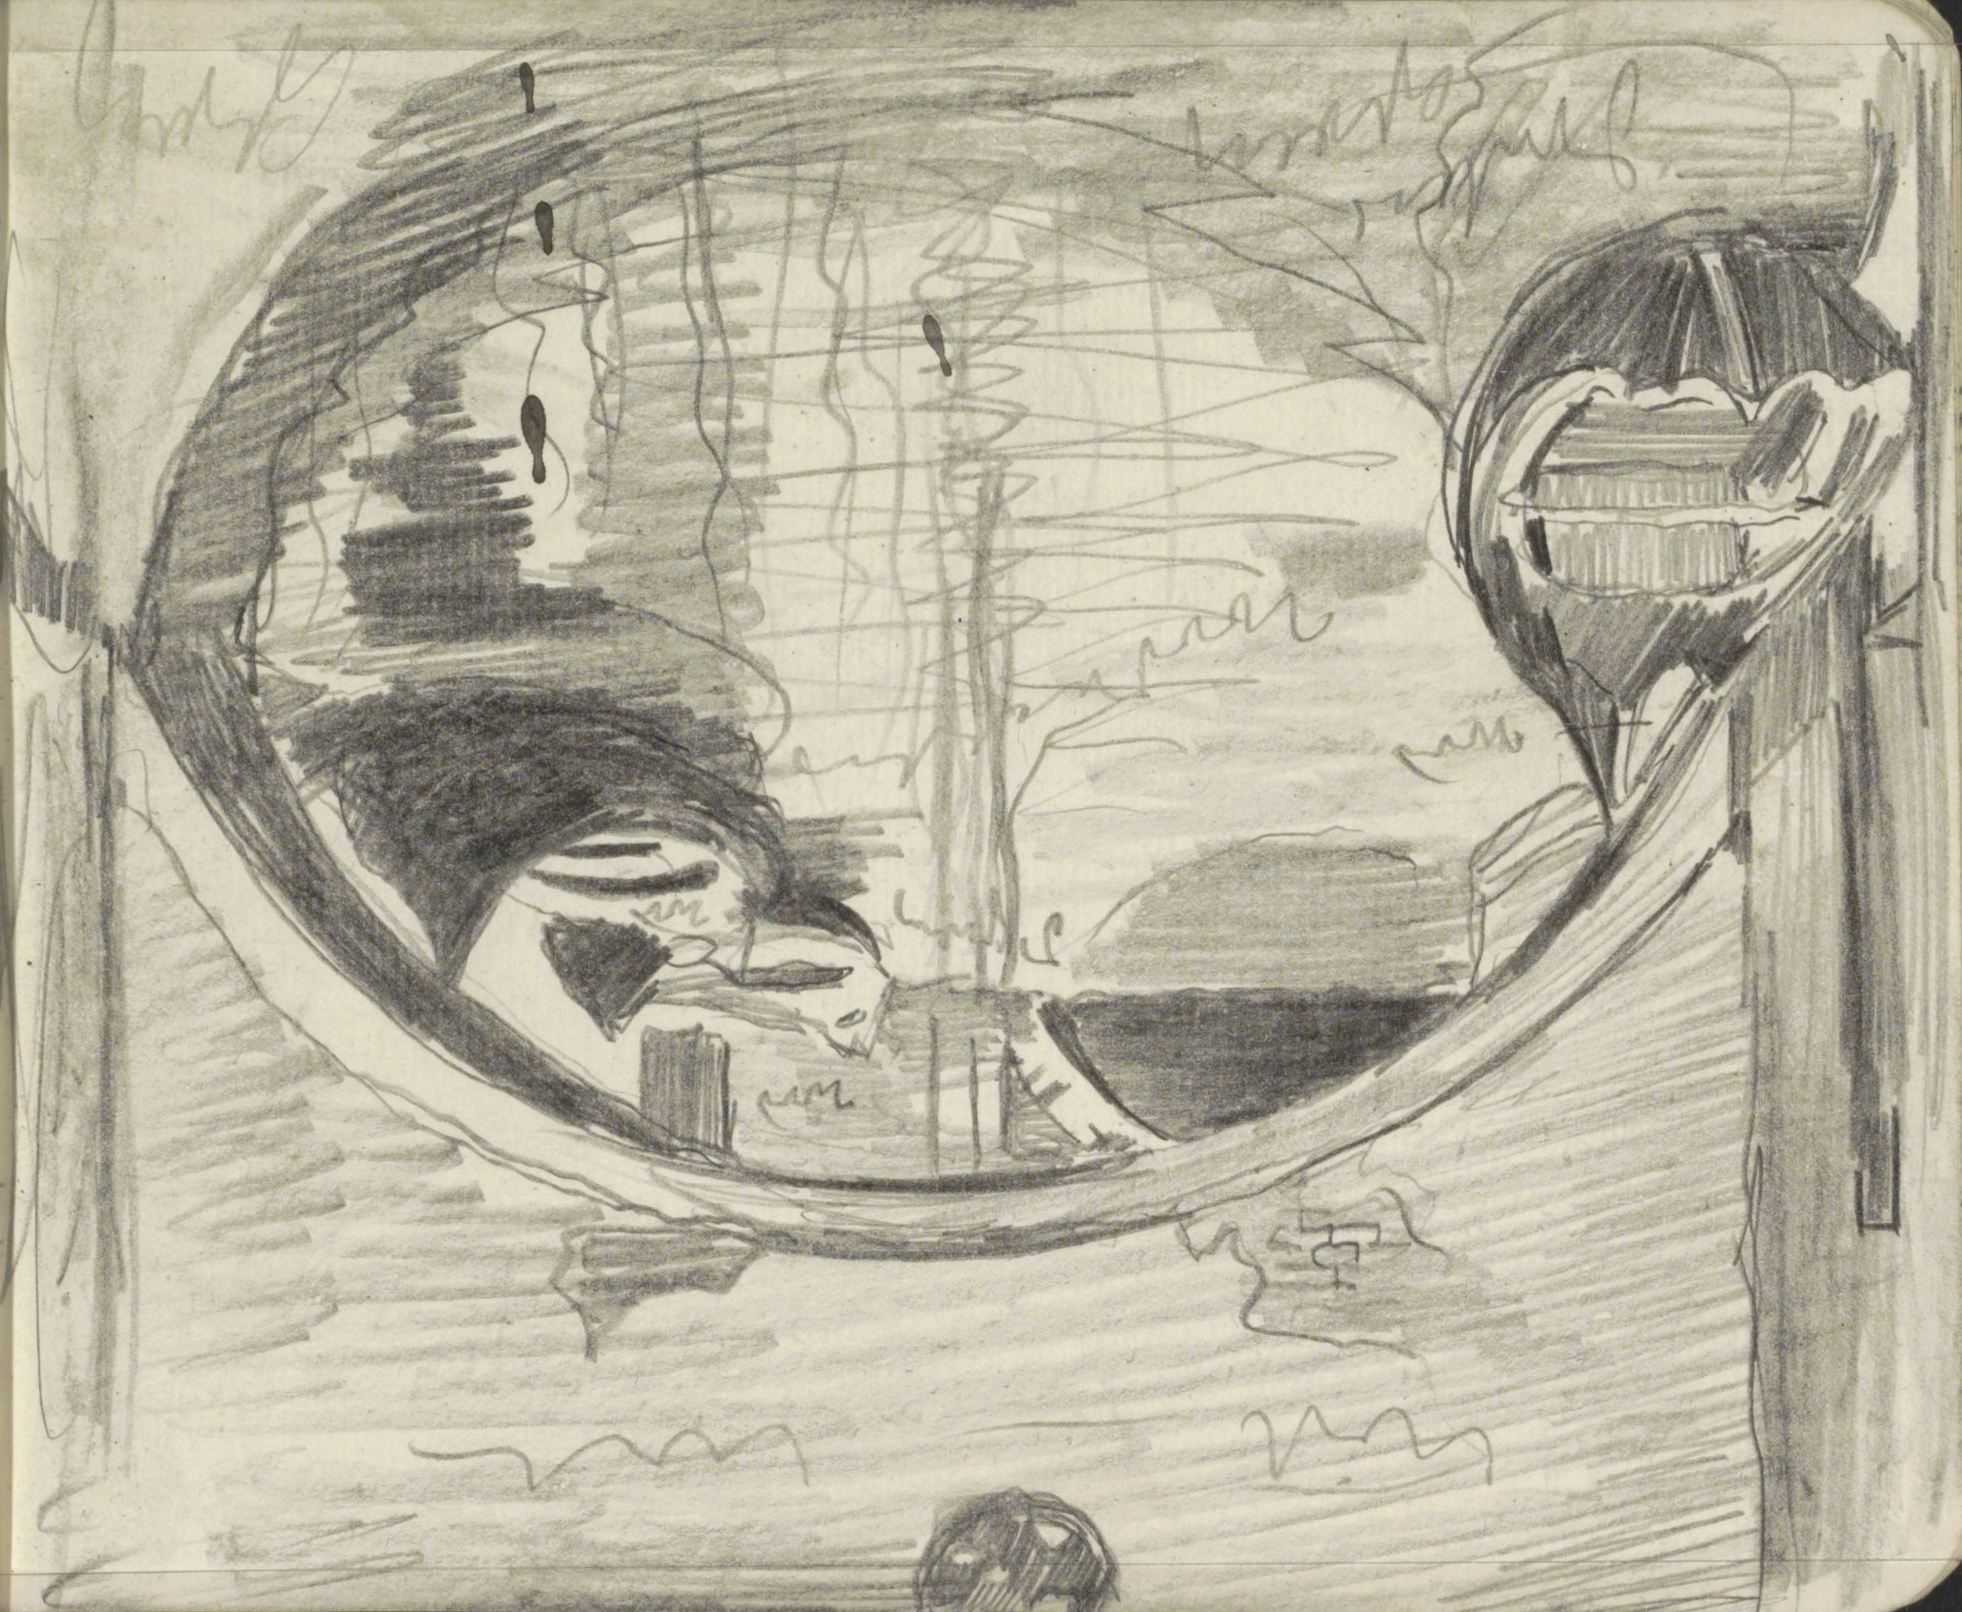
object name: sketchbook leaf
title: Gondels onder een brug in Venetië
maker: willem witsen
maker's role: draughtsman, painter, print maker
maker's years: 1860-1923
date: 1914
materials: paper, pencil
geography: venice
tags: bridge in city across river, canal, etc., gondola, venice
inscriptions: watermark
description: Voorstudie voor de ets 'Onder de brug, Venetië', ca. 1914-1919.